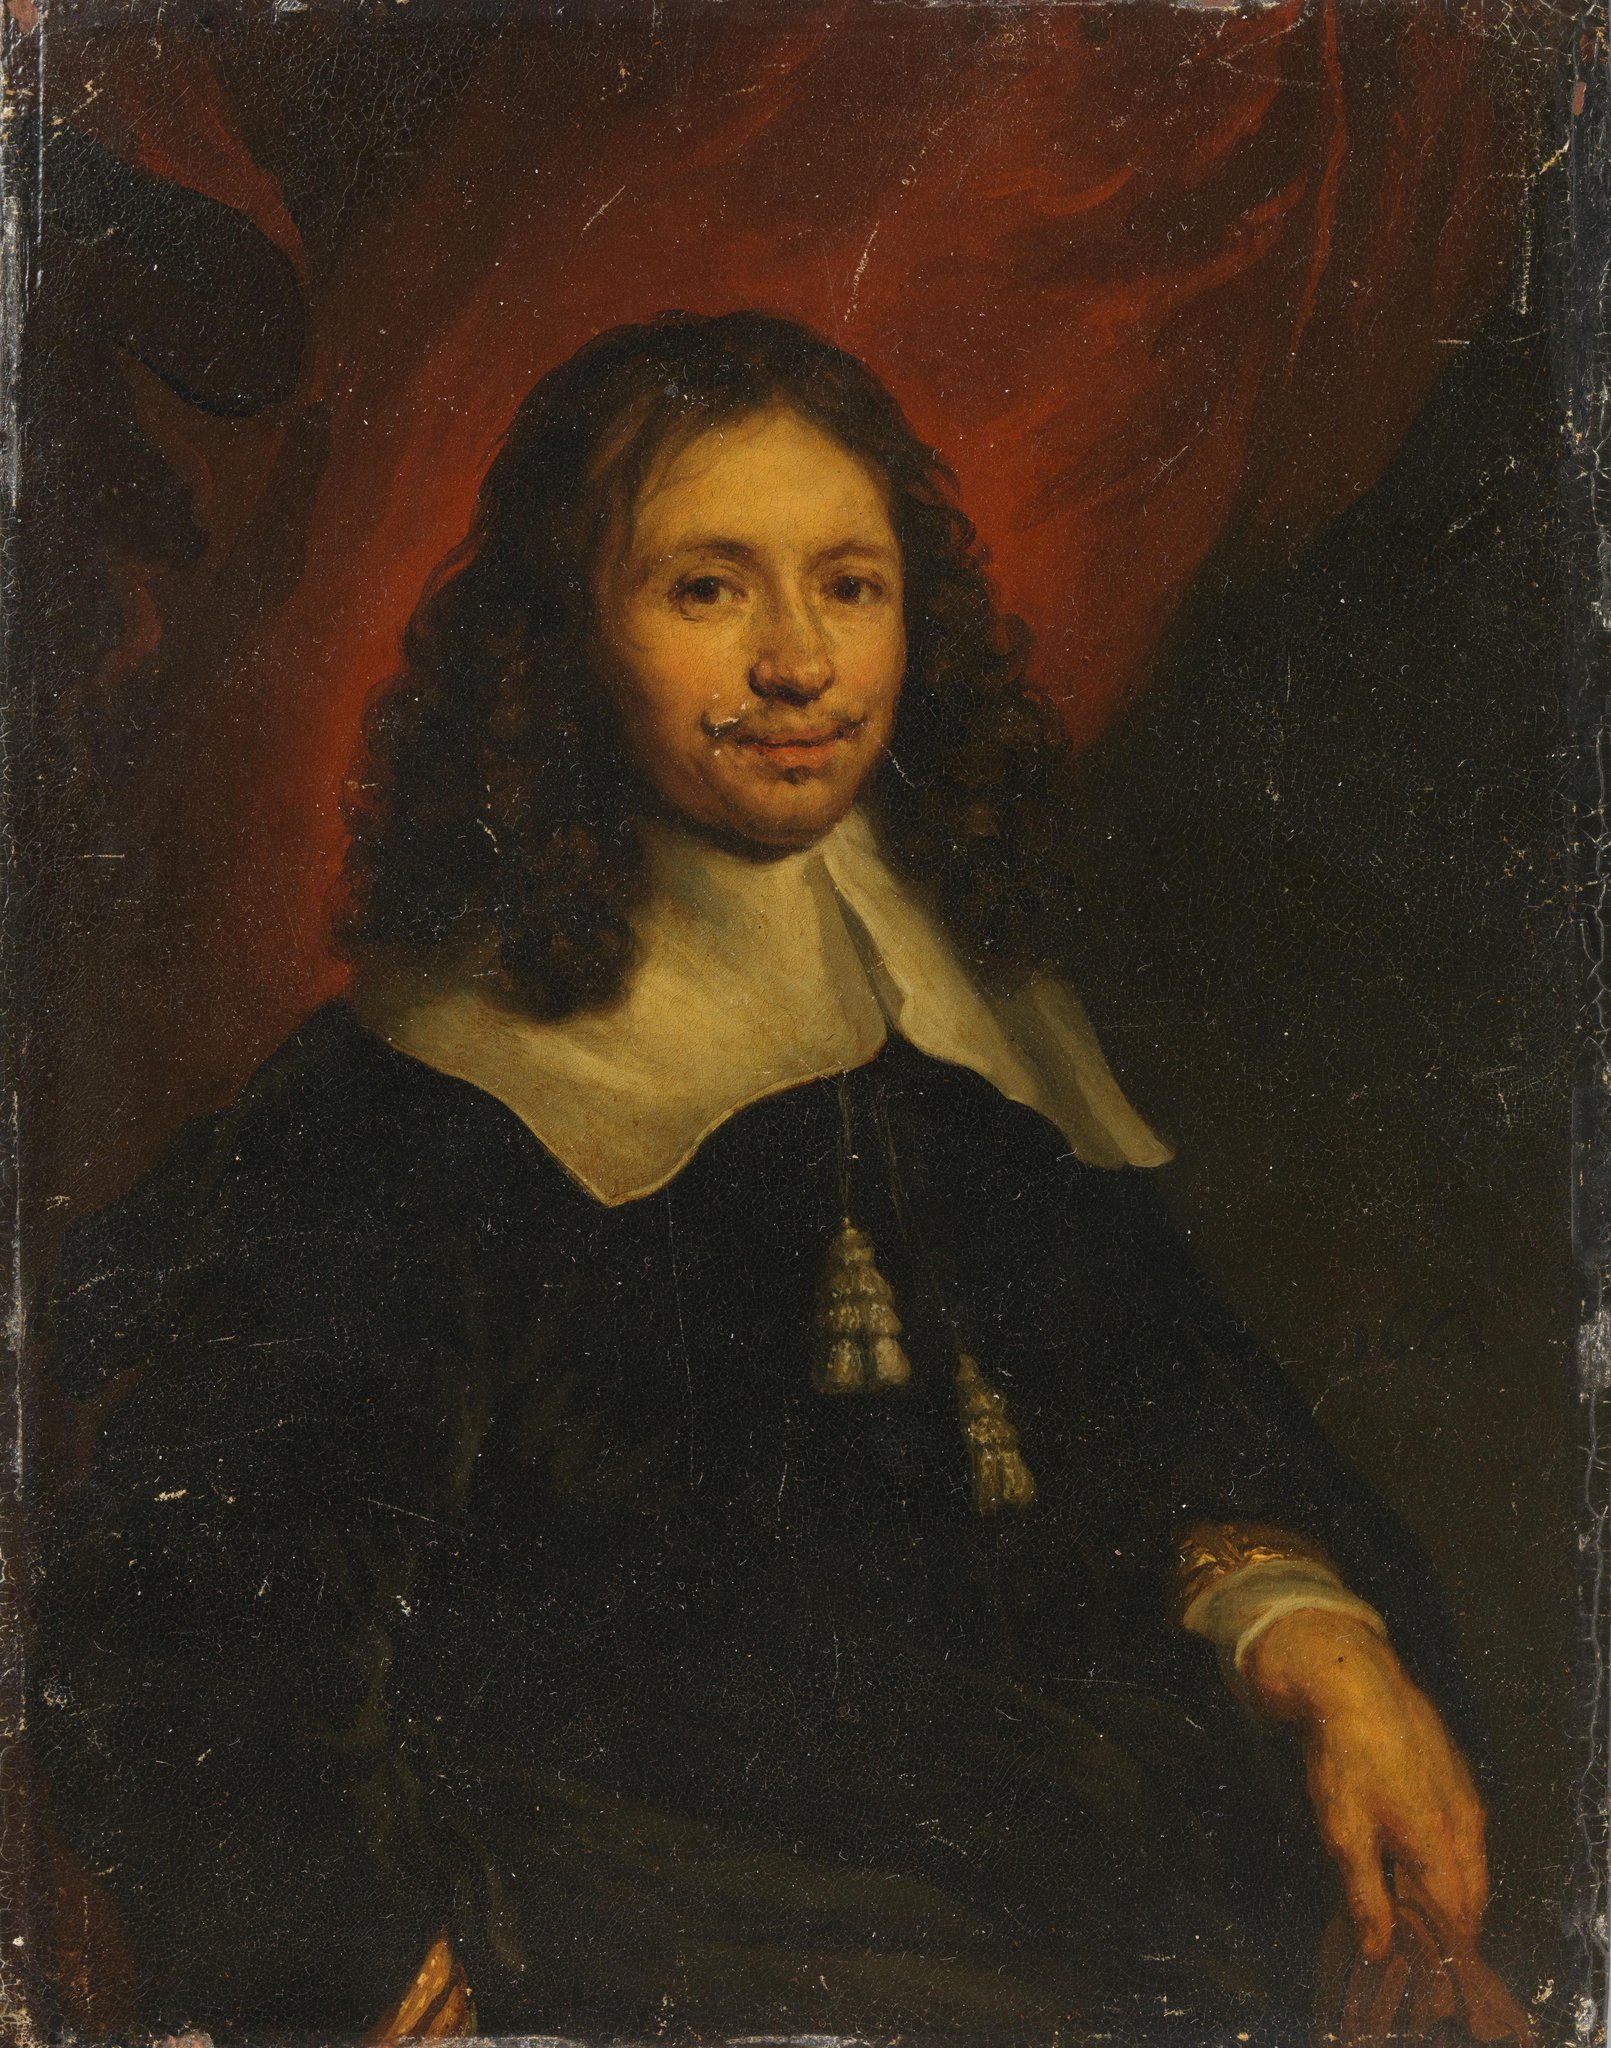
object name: painting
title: Portrait of Dionijs Wijnands, Merchant in Amsterdam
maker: jan van noordt (1623-1676)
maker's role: draughtsman, painter, print maker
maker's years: 1623-1676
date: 1664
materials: copper, oil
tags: historical persons, merchant, salesman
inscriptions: date: ‘1664’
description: Portret van Dionijs Wijnands (1628-73), koopman te Amsterdam. Ten halven lijve, zittend voor een gordijn.